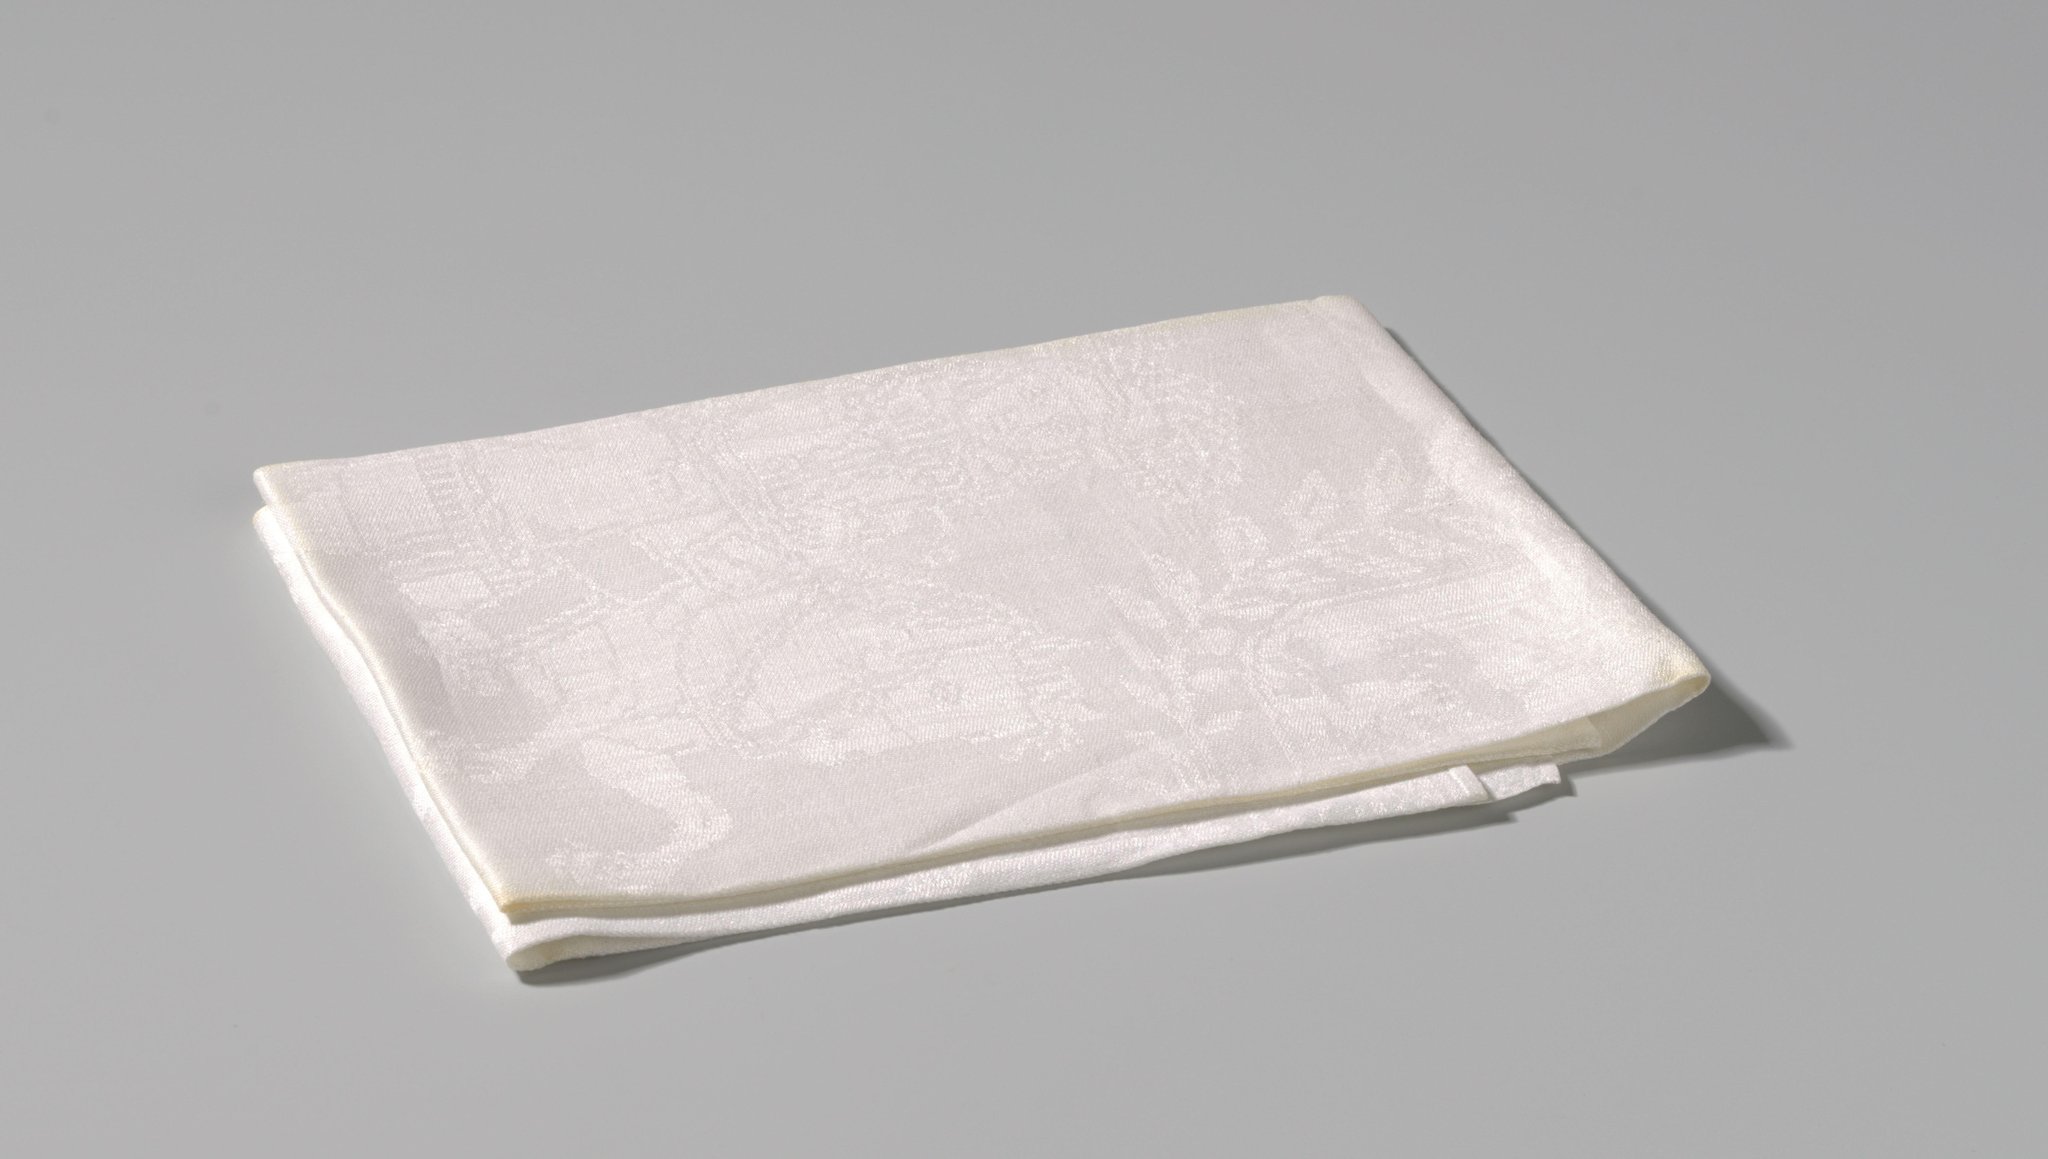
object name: napkin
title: Servet met de verovering van Neuhäusel, Gran, Buda en Pest door Leopold I, keizer van Duitsland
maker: Anonymous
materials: linen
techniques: damask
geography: flanders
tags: vienna, leopold i (keizer van duitsland)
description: Servet van linnendamast met de verovering van Neuhäusel, Gran, Buda en Pest door Leopold I; met het wapen van het Heilige Roomse Rijk met hartschild Oosterijk.